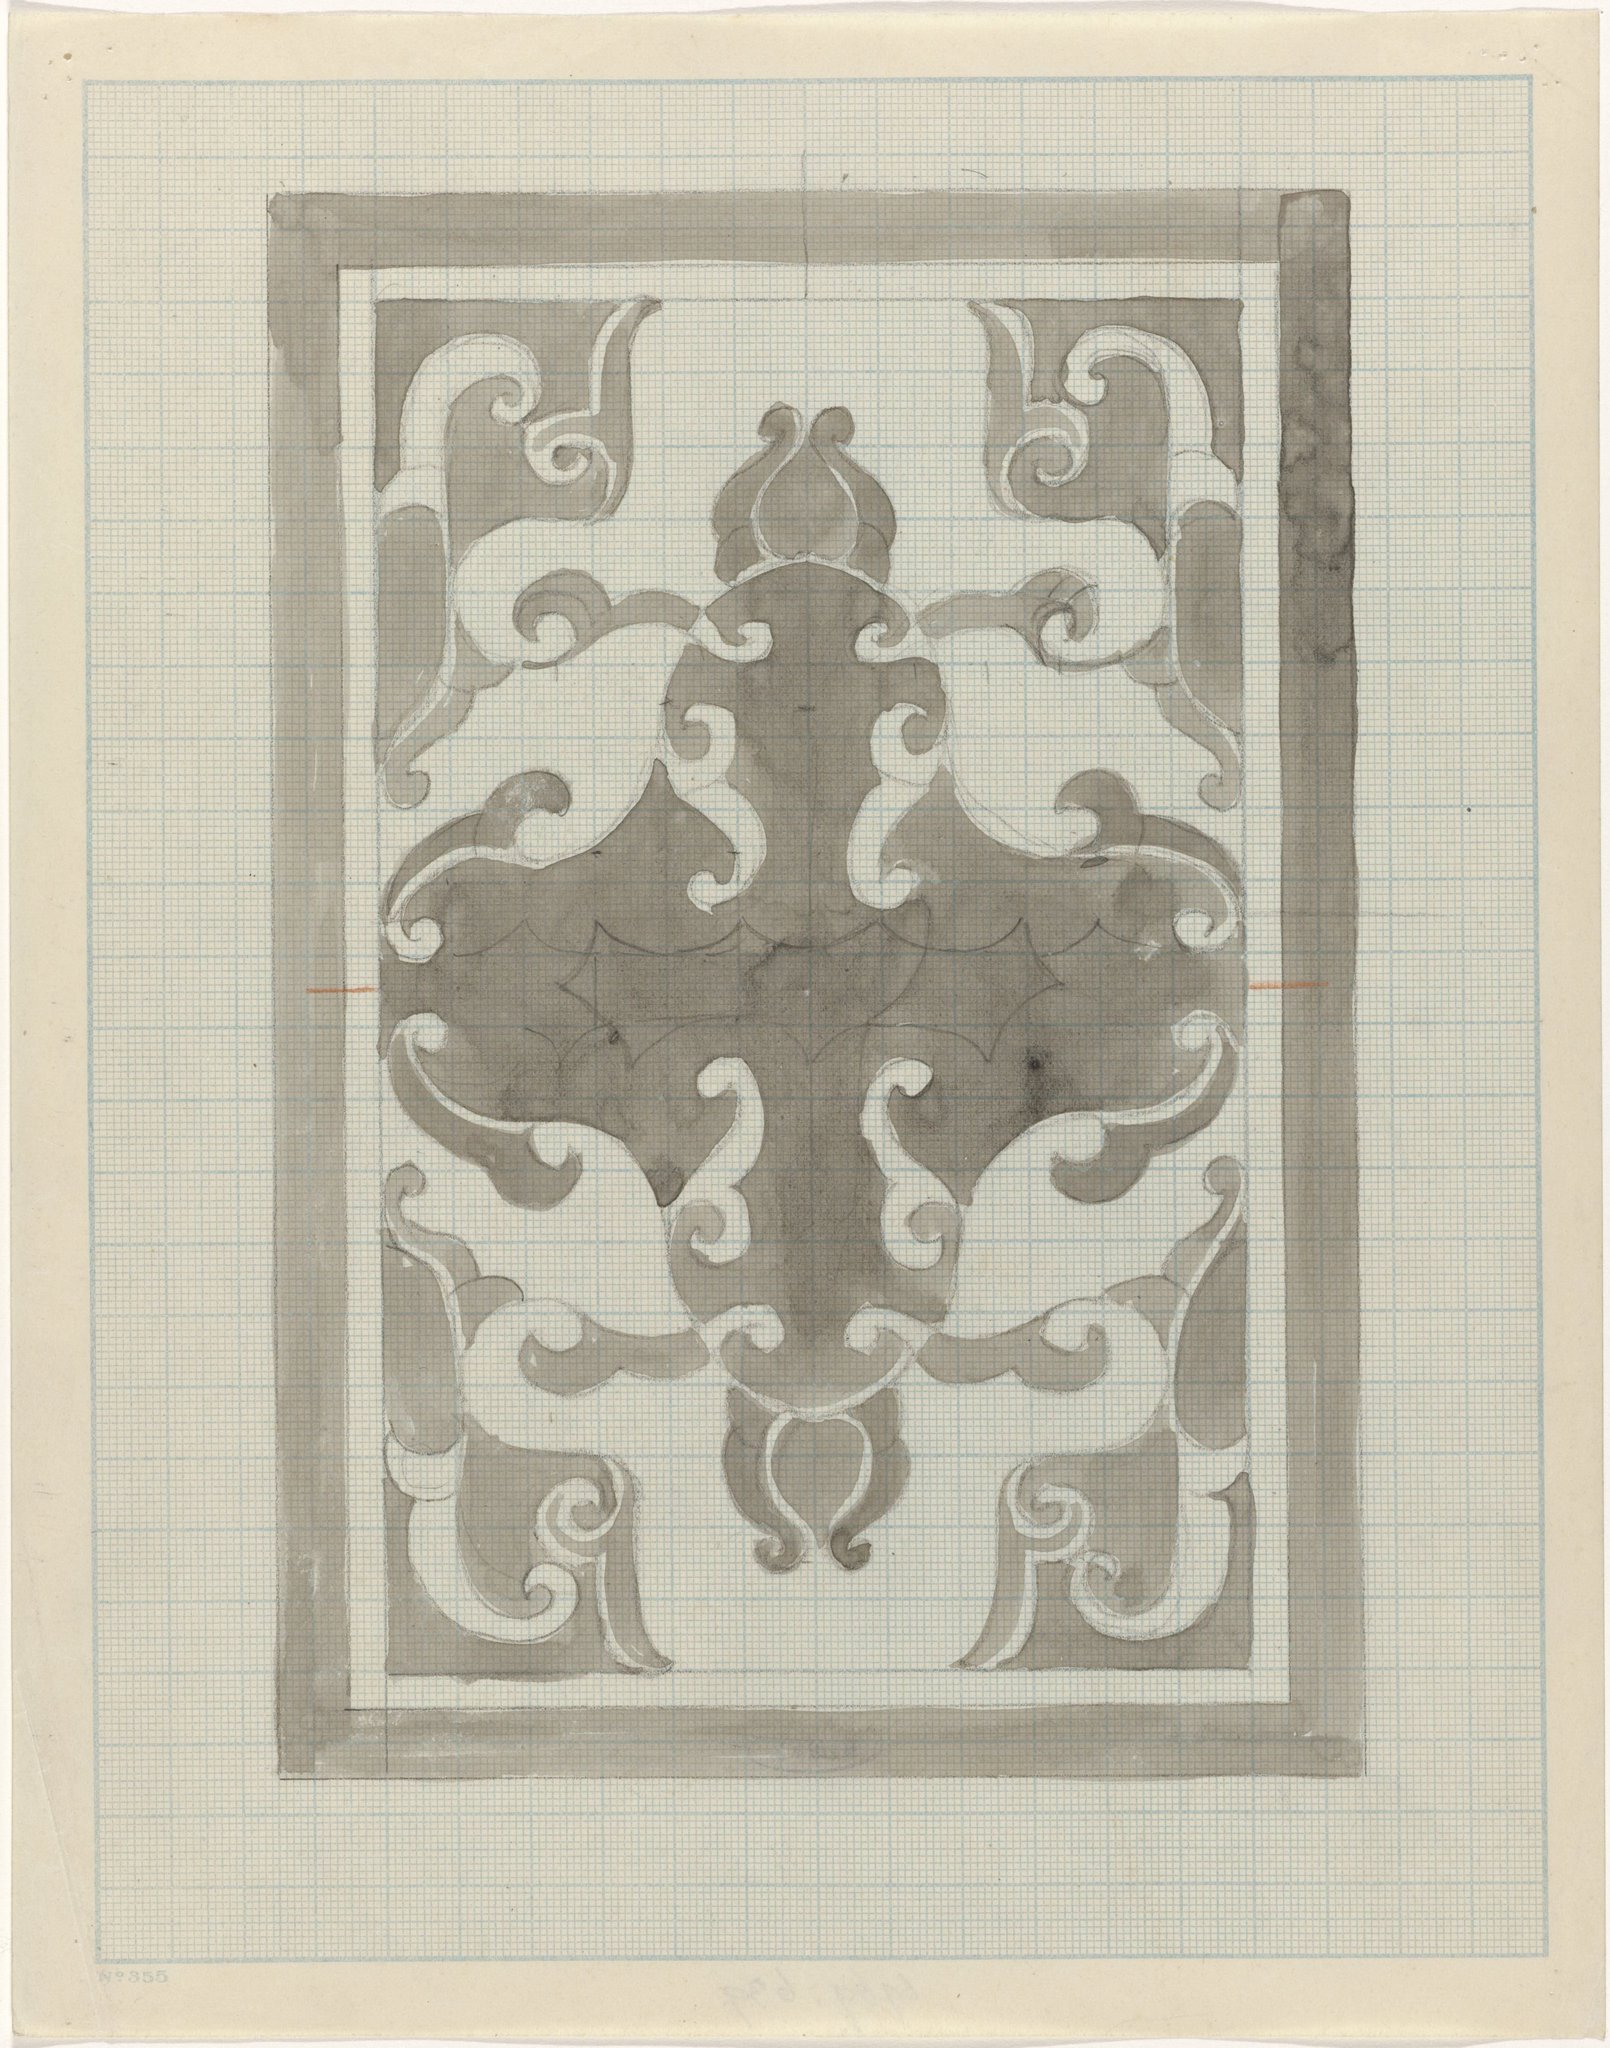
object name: design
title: Decoratief ontwerp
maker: carel adolph lion cachet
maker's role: draughtsman, print maker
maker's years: 1864-1945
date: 1874-1945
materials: pencil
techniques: brush